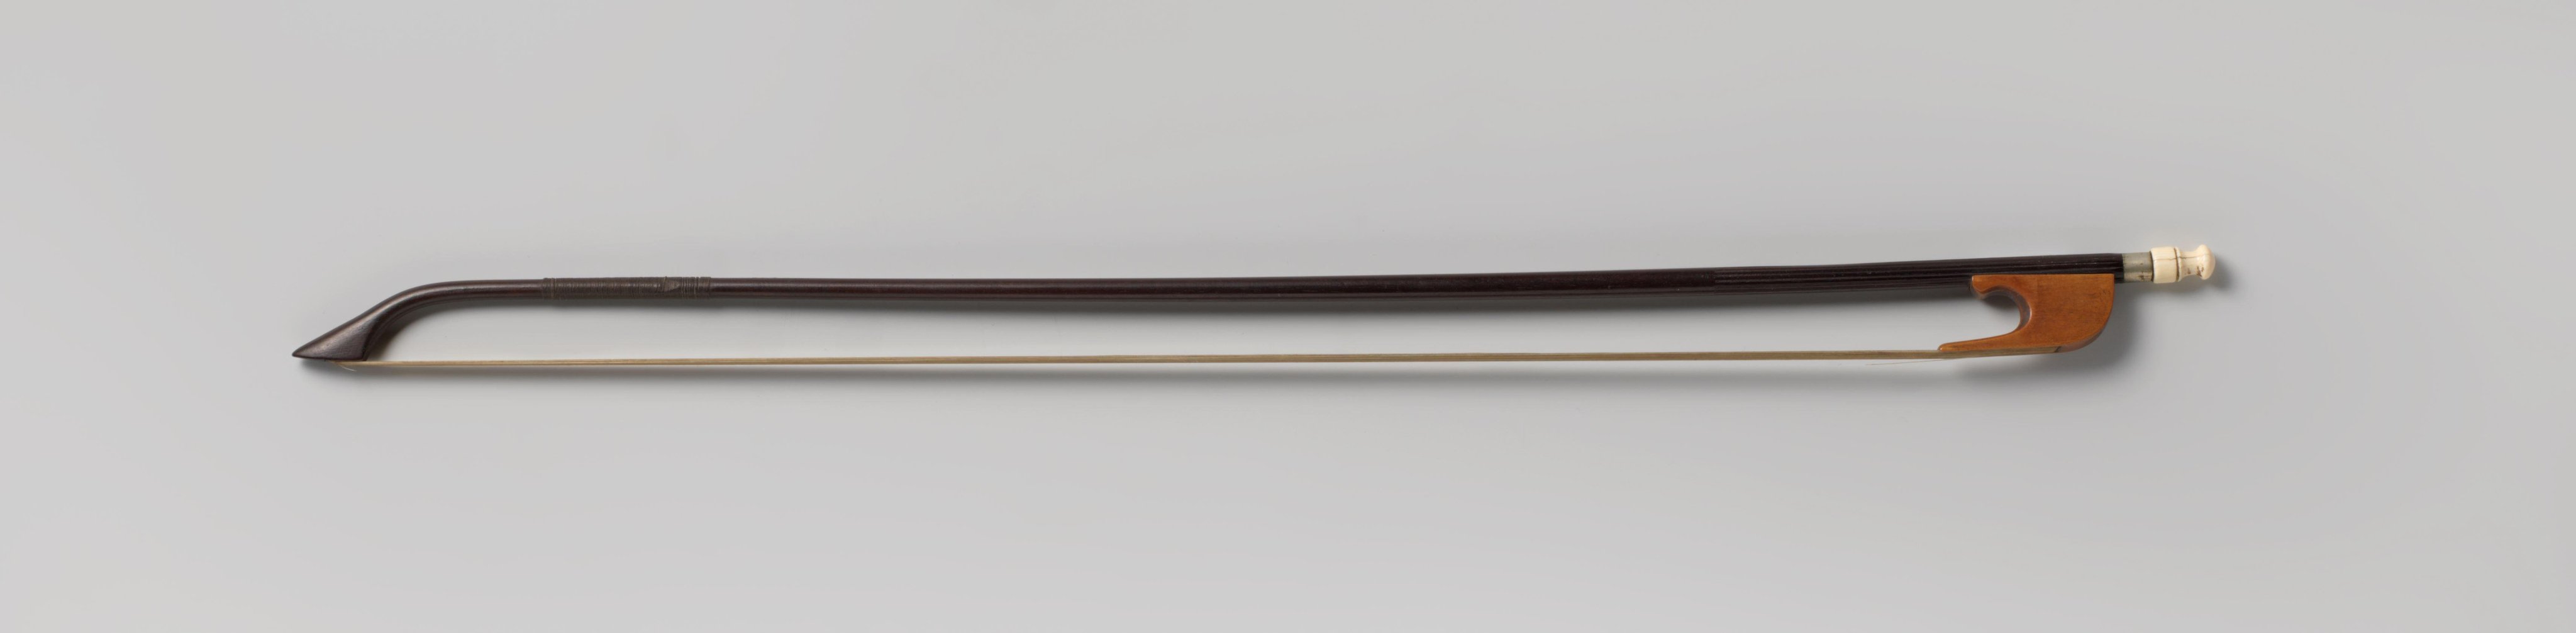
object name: kit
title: Bow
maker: Anonymous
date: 1700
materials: wood